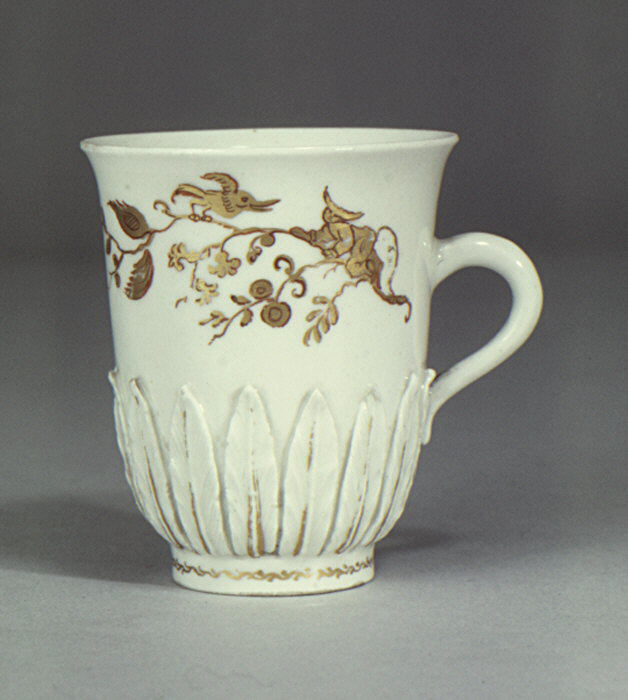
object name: cup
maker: meissen manufactory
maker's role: manufactory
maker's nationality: german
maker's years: 1710-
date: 1713-1715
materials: hard paste porcelain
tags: birds